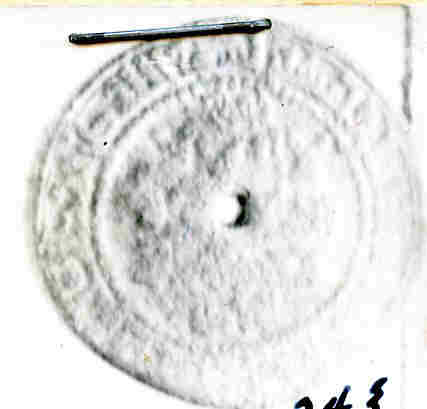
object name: coin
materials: copper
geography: iran